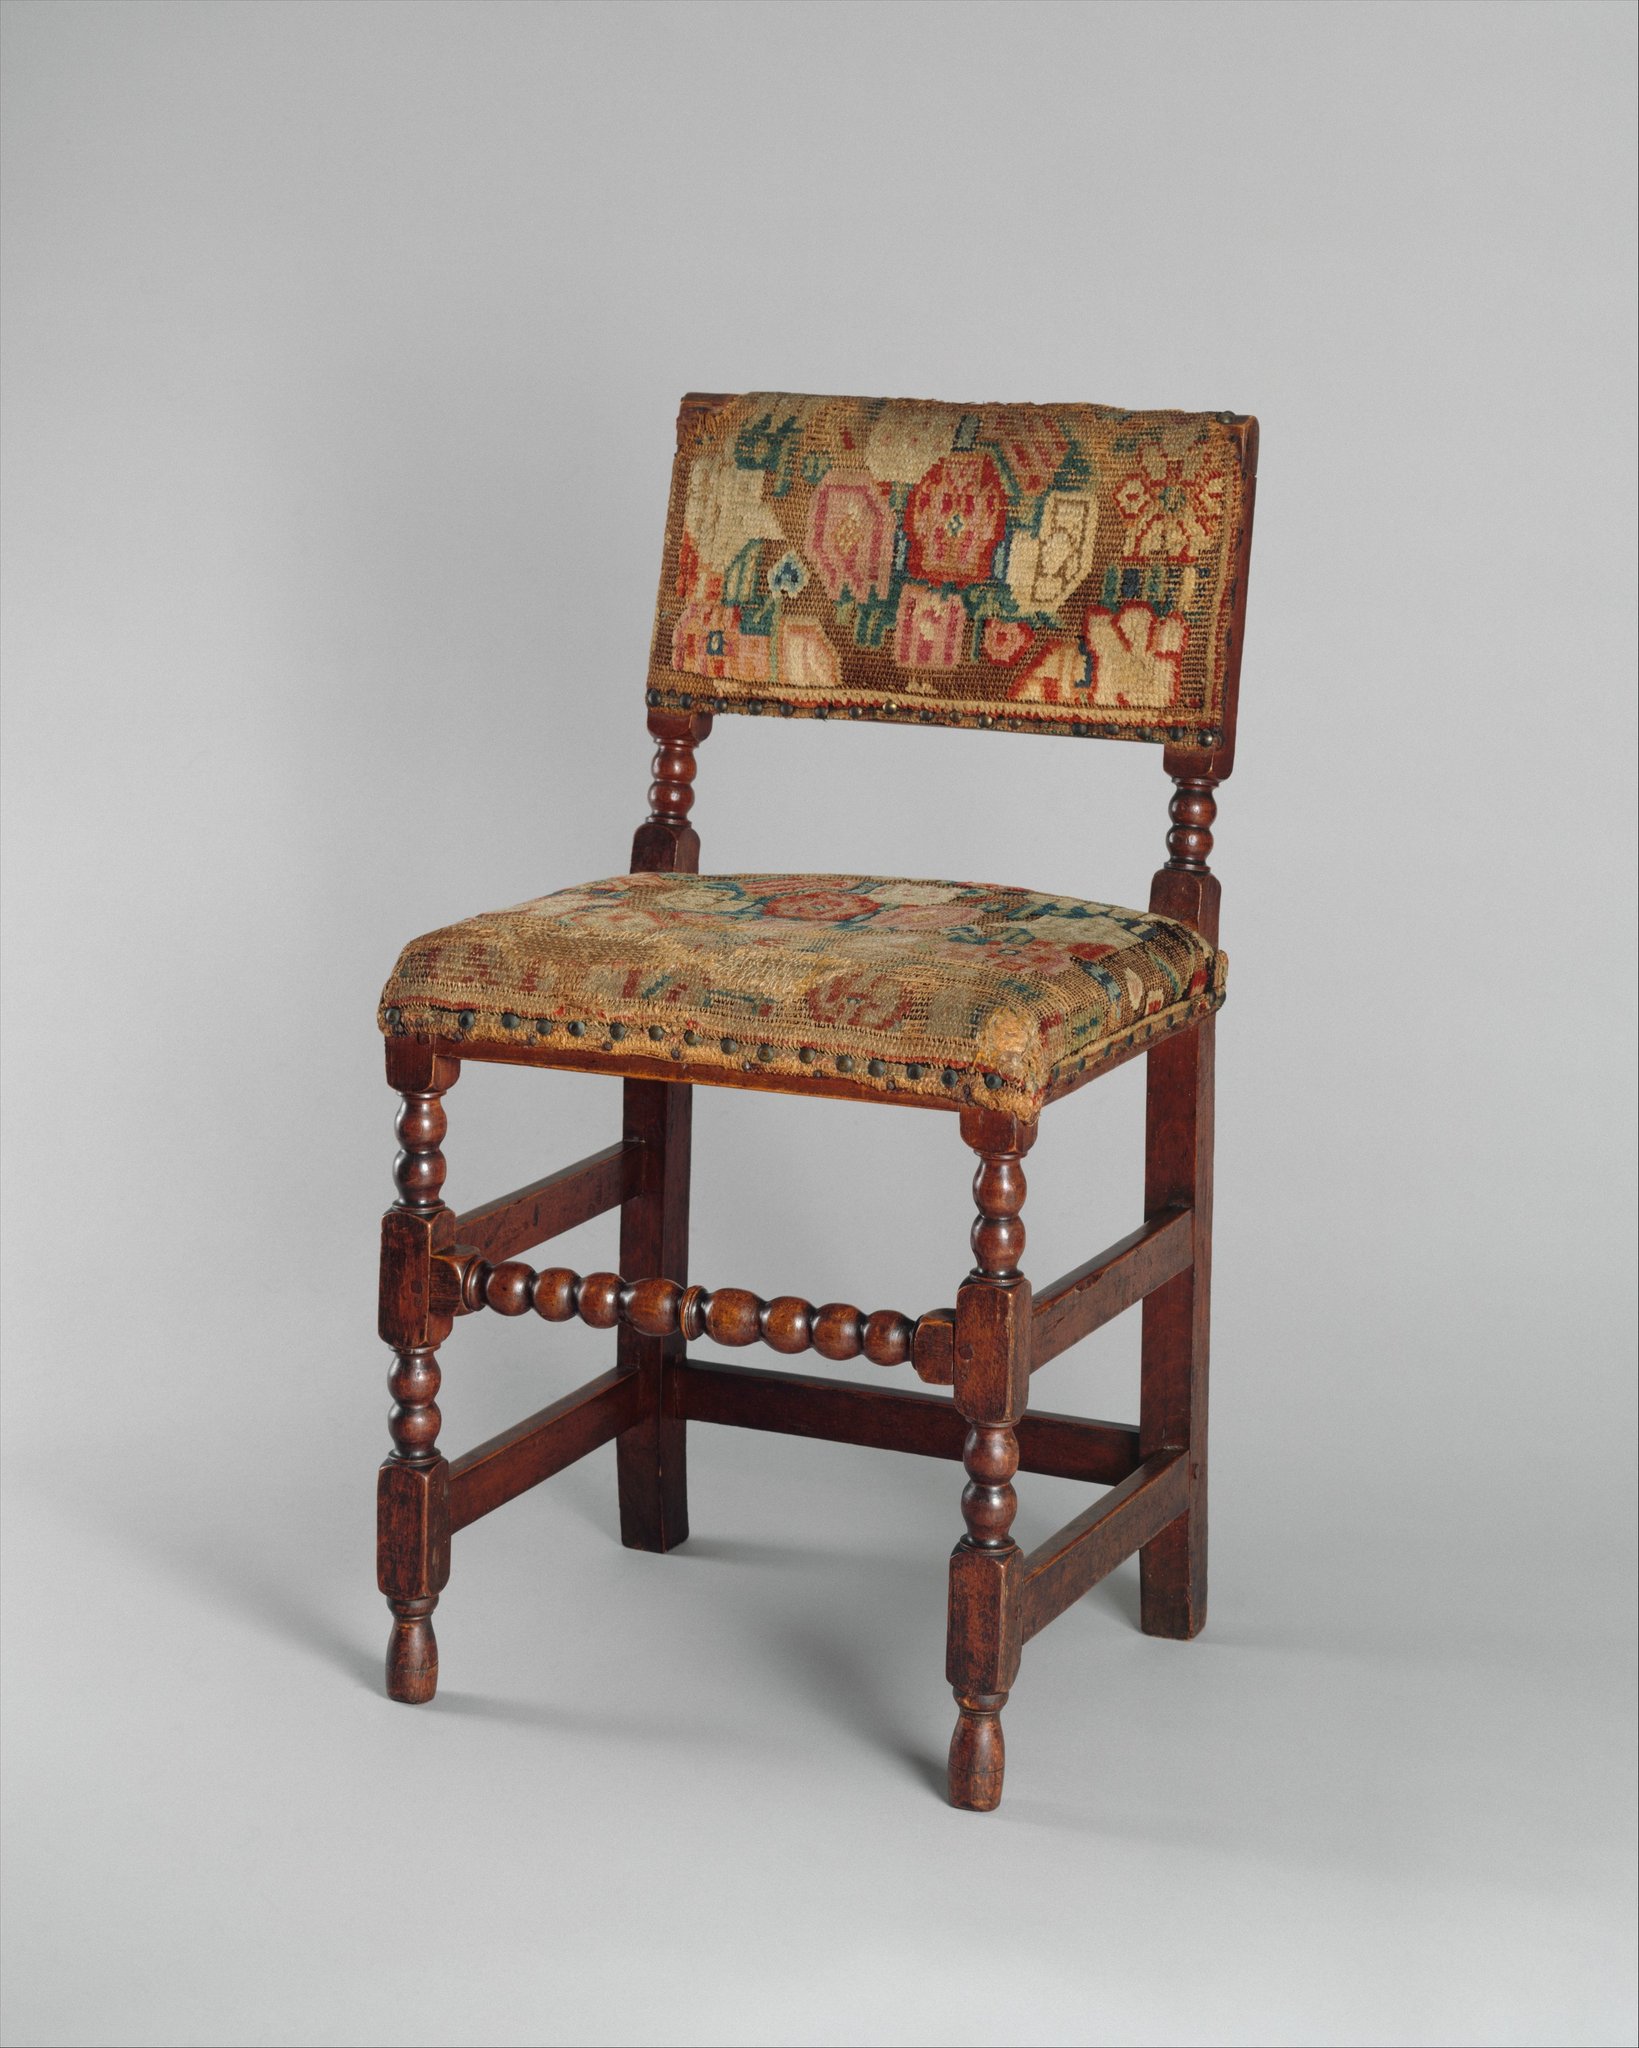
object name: side chair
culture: american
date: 1660-1690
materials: wood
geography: united states